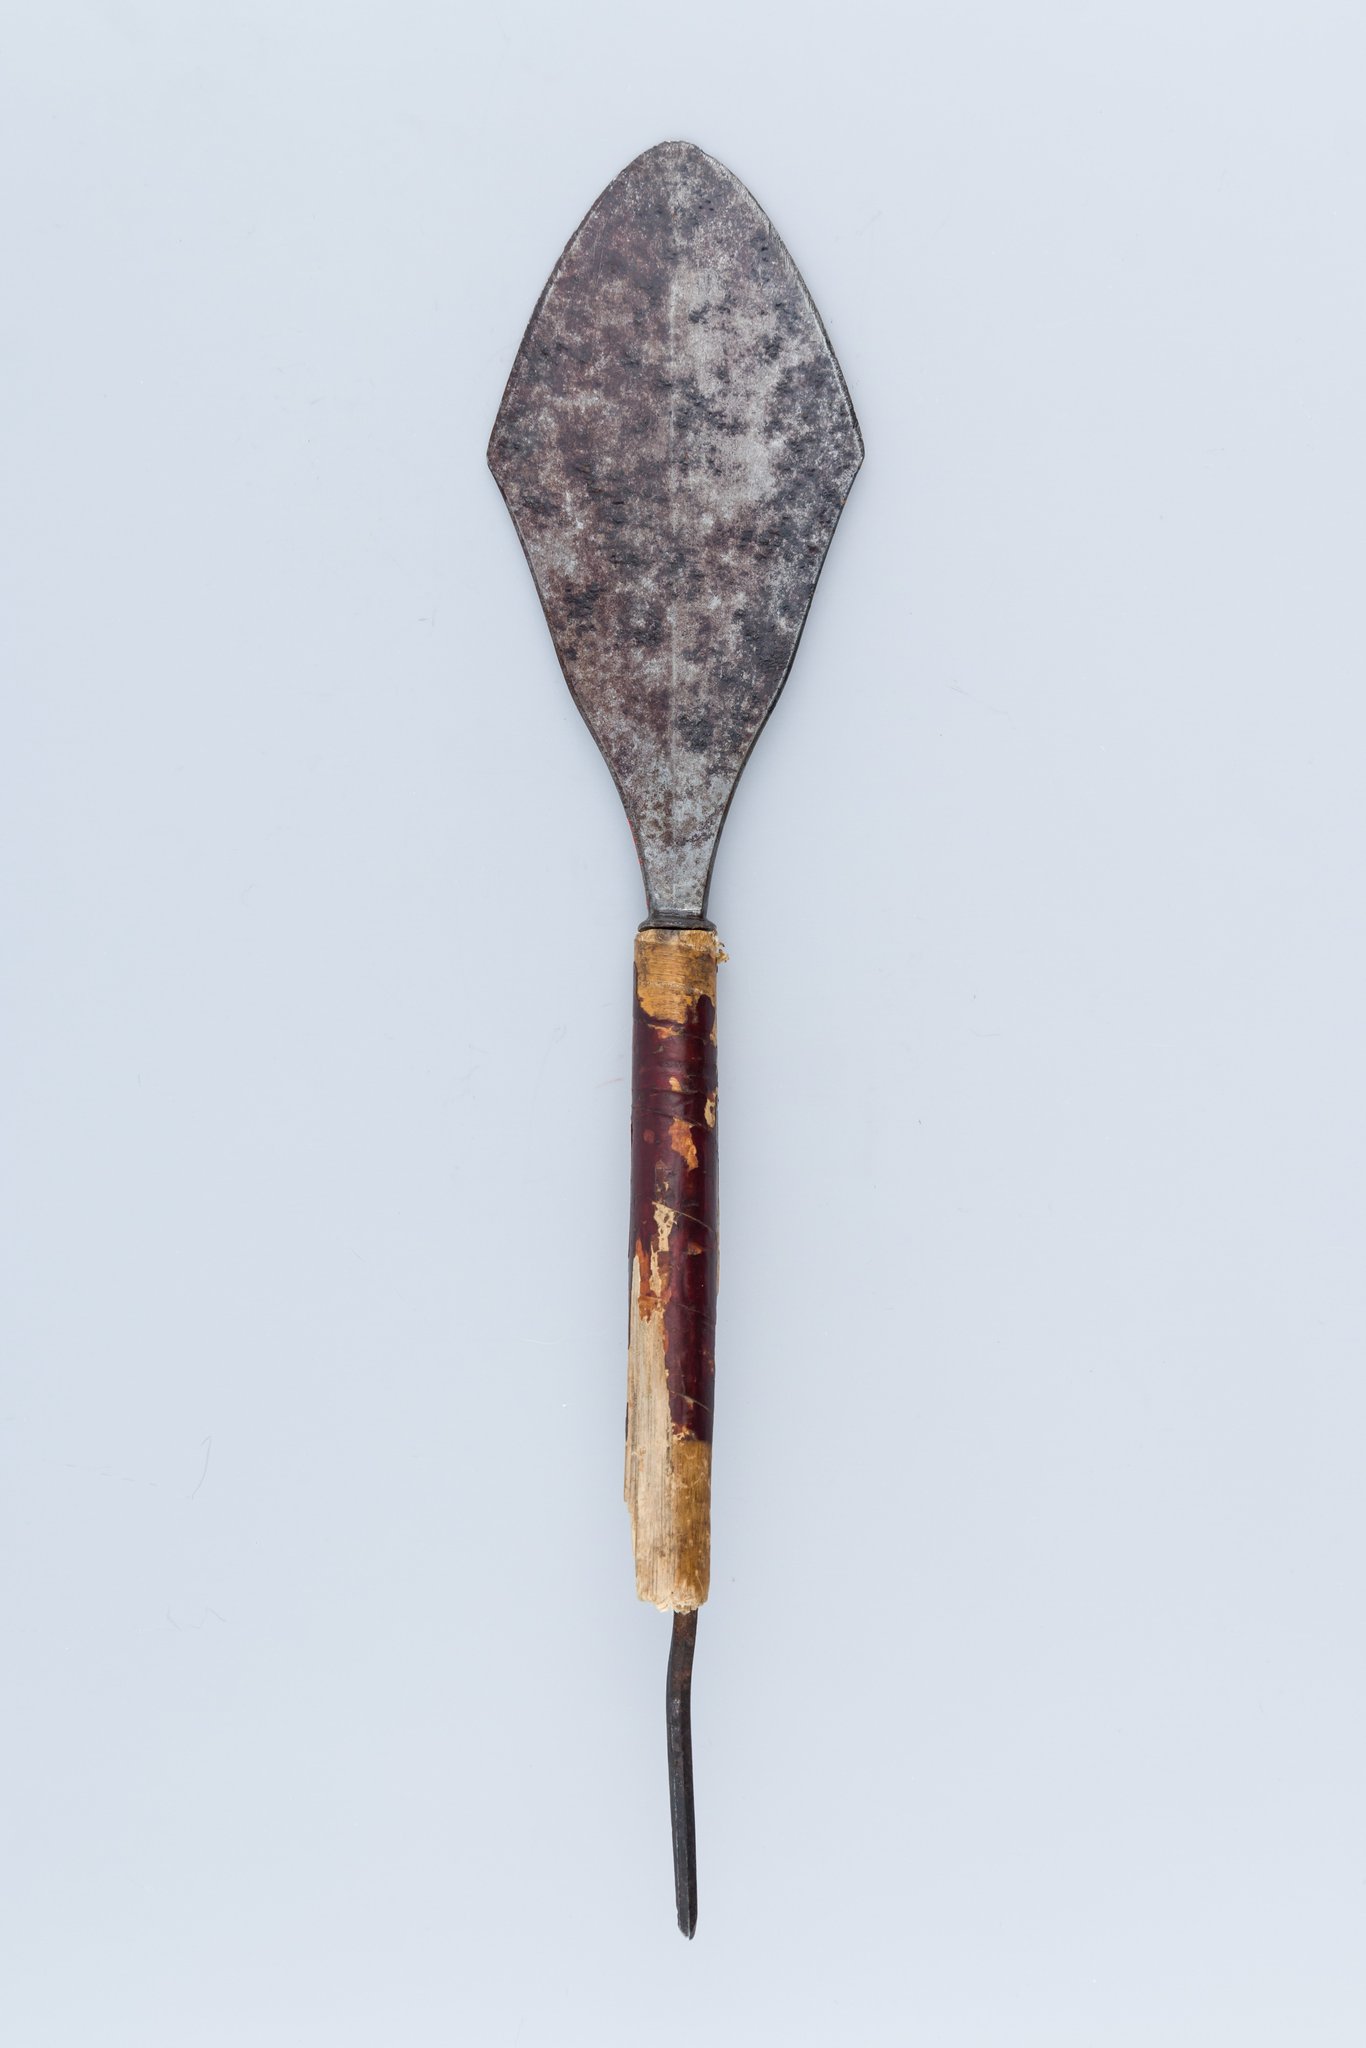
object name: arrowhead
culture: tibetan or chinese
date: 1701-1900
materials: iron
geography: china